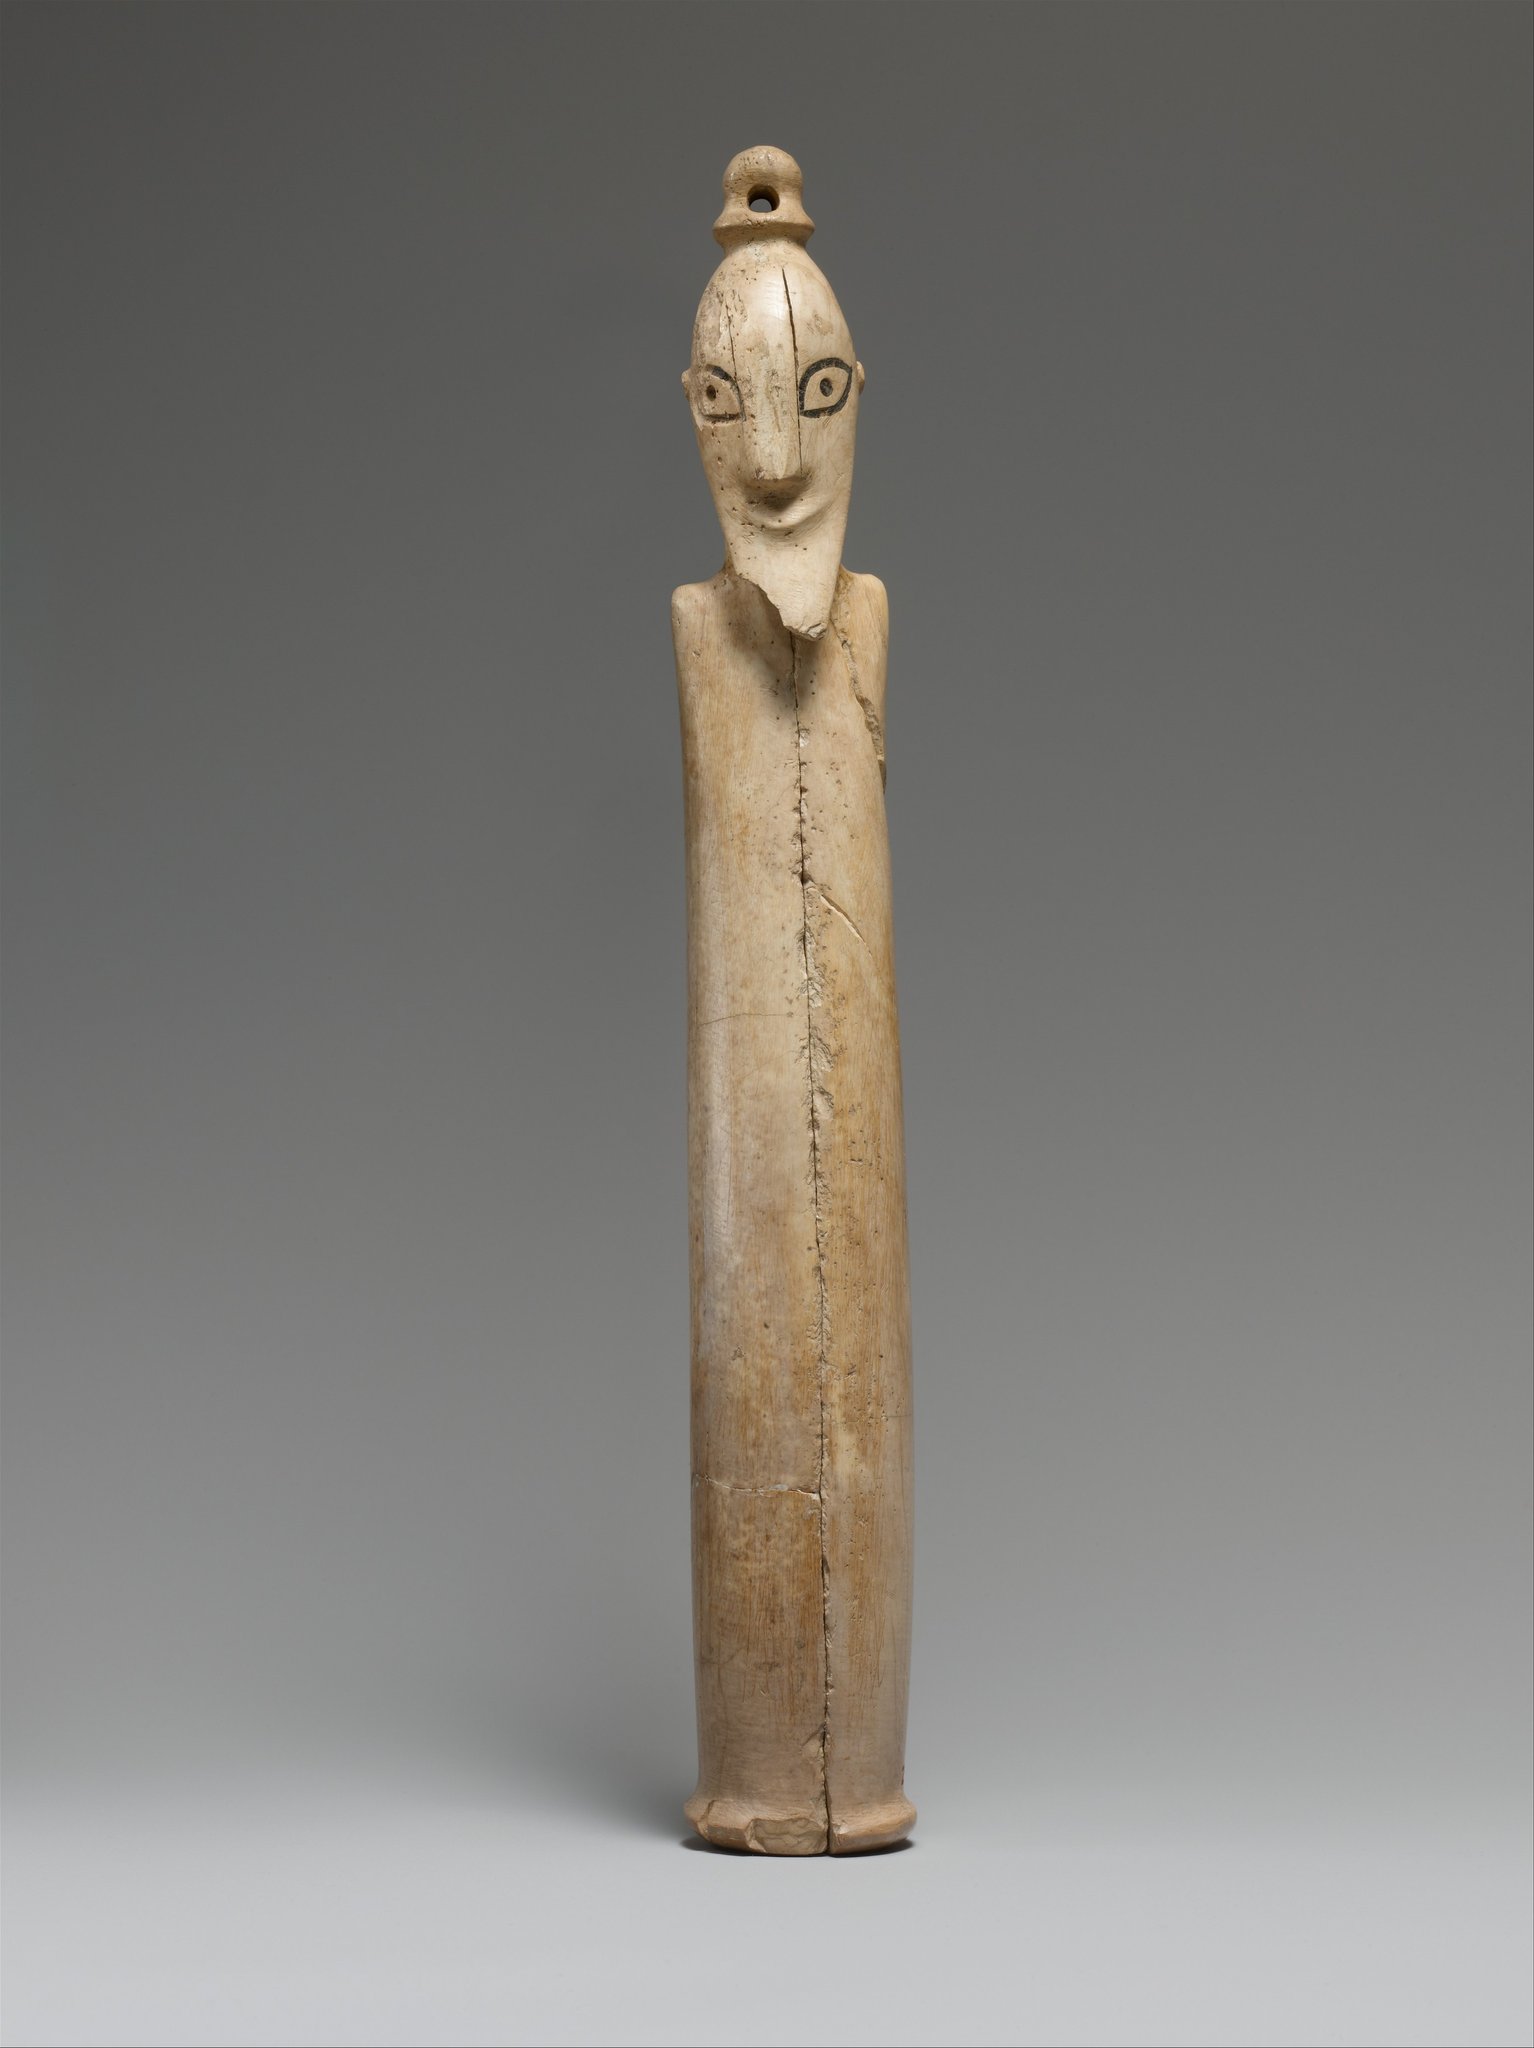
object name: statuette, tusk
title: A Tusk Figurine of a Man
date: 3900-3500 BCE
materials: ivory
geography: egypt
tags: men